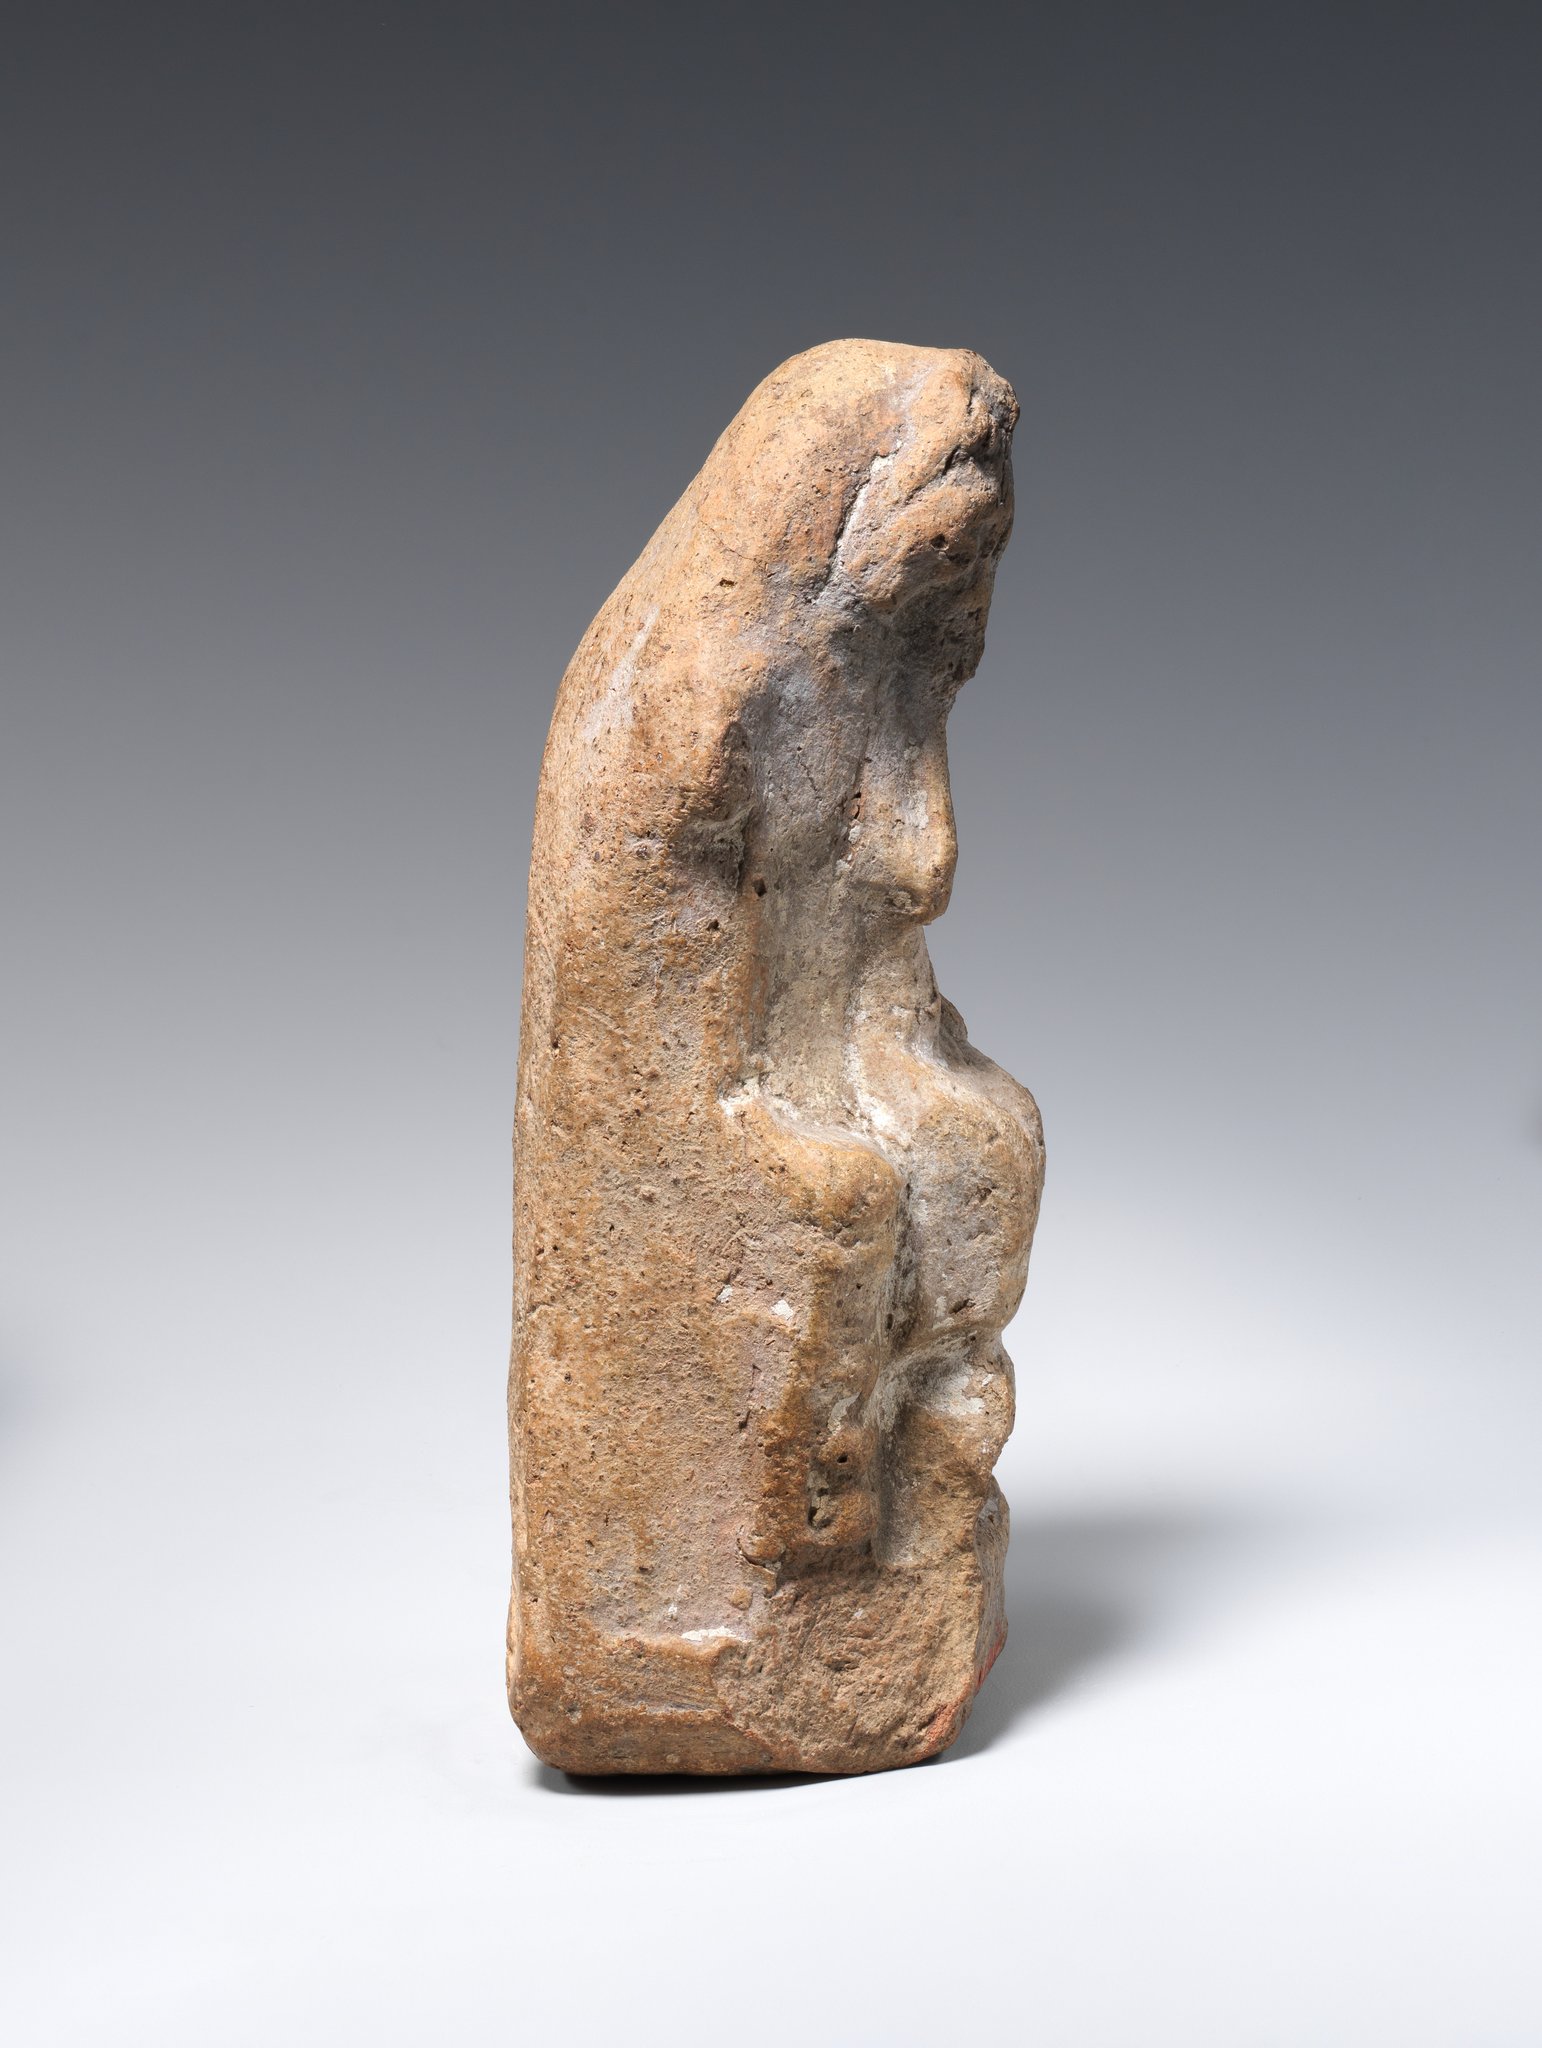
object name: figurine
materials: terracotta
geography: egypt